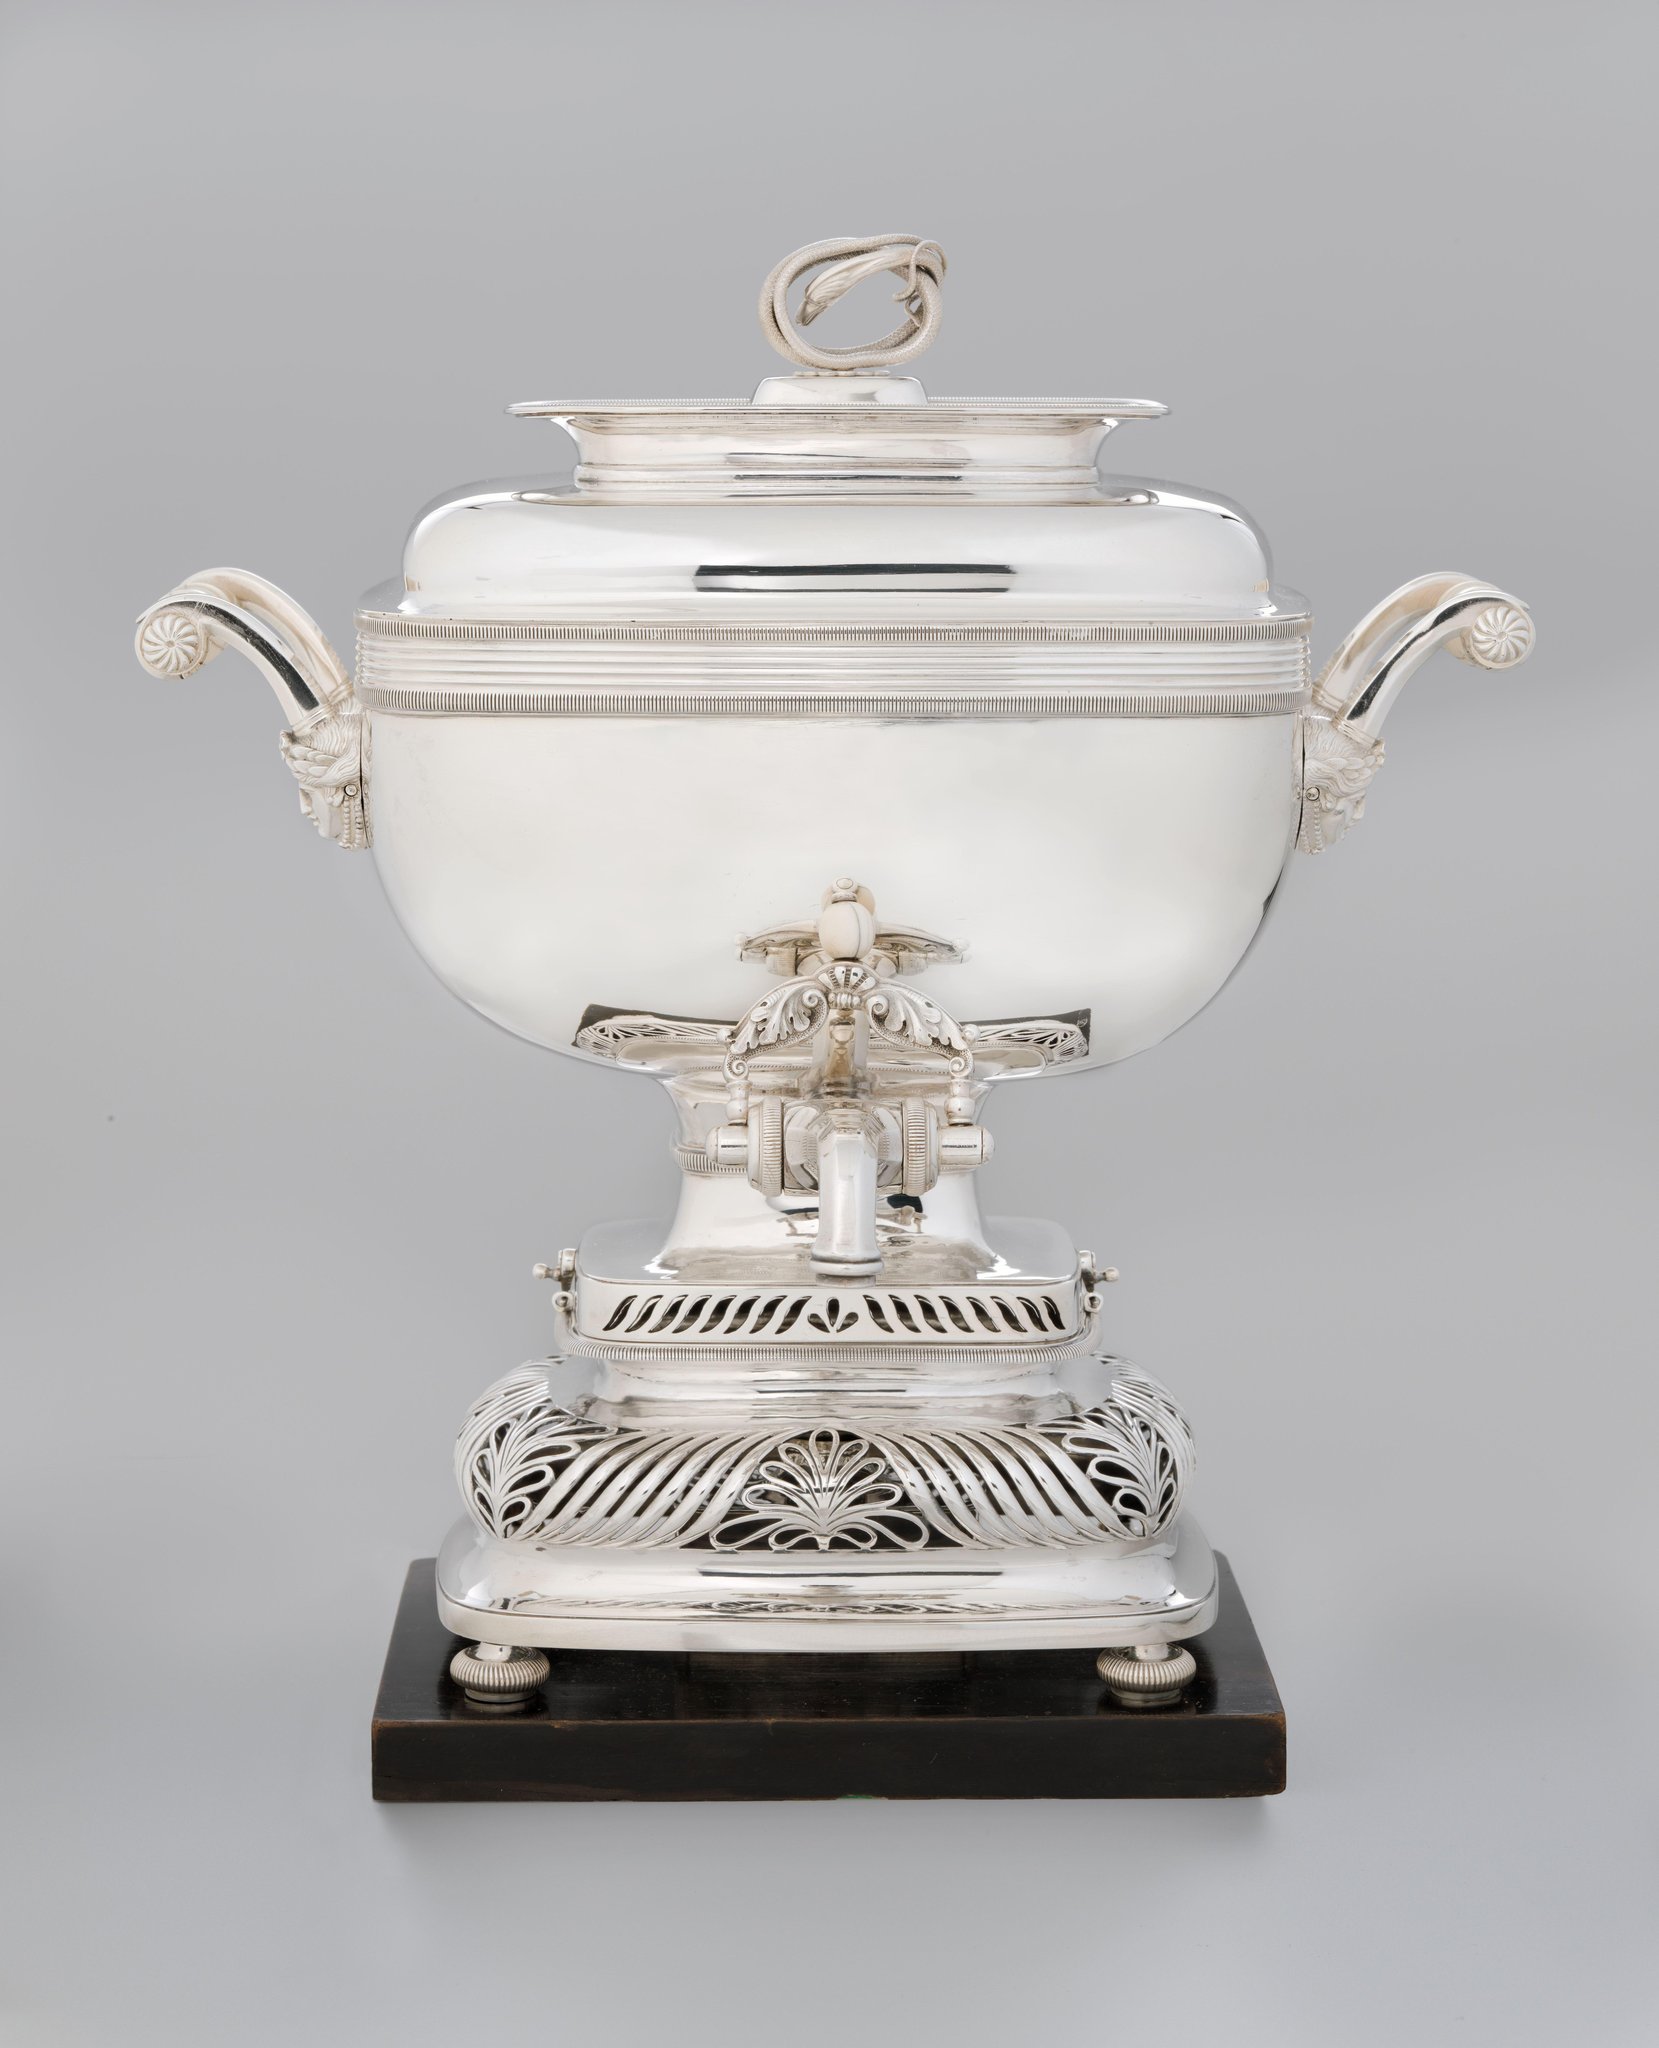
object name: komfoor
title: Tea urn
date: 1828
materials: ivory, silver, wood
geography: amsterdam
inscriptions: alloy mark, date letter: ‘T’, maker's mark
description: This may have been intended as a tea urn, but it could also be meant to contain coffee. Cups were placed underneath the spigot to be filled. The plain shape is characteristic of Amsterdam silver of the early 19th century.